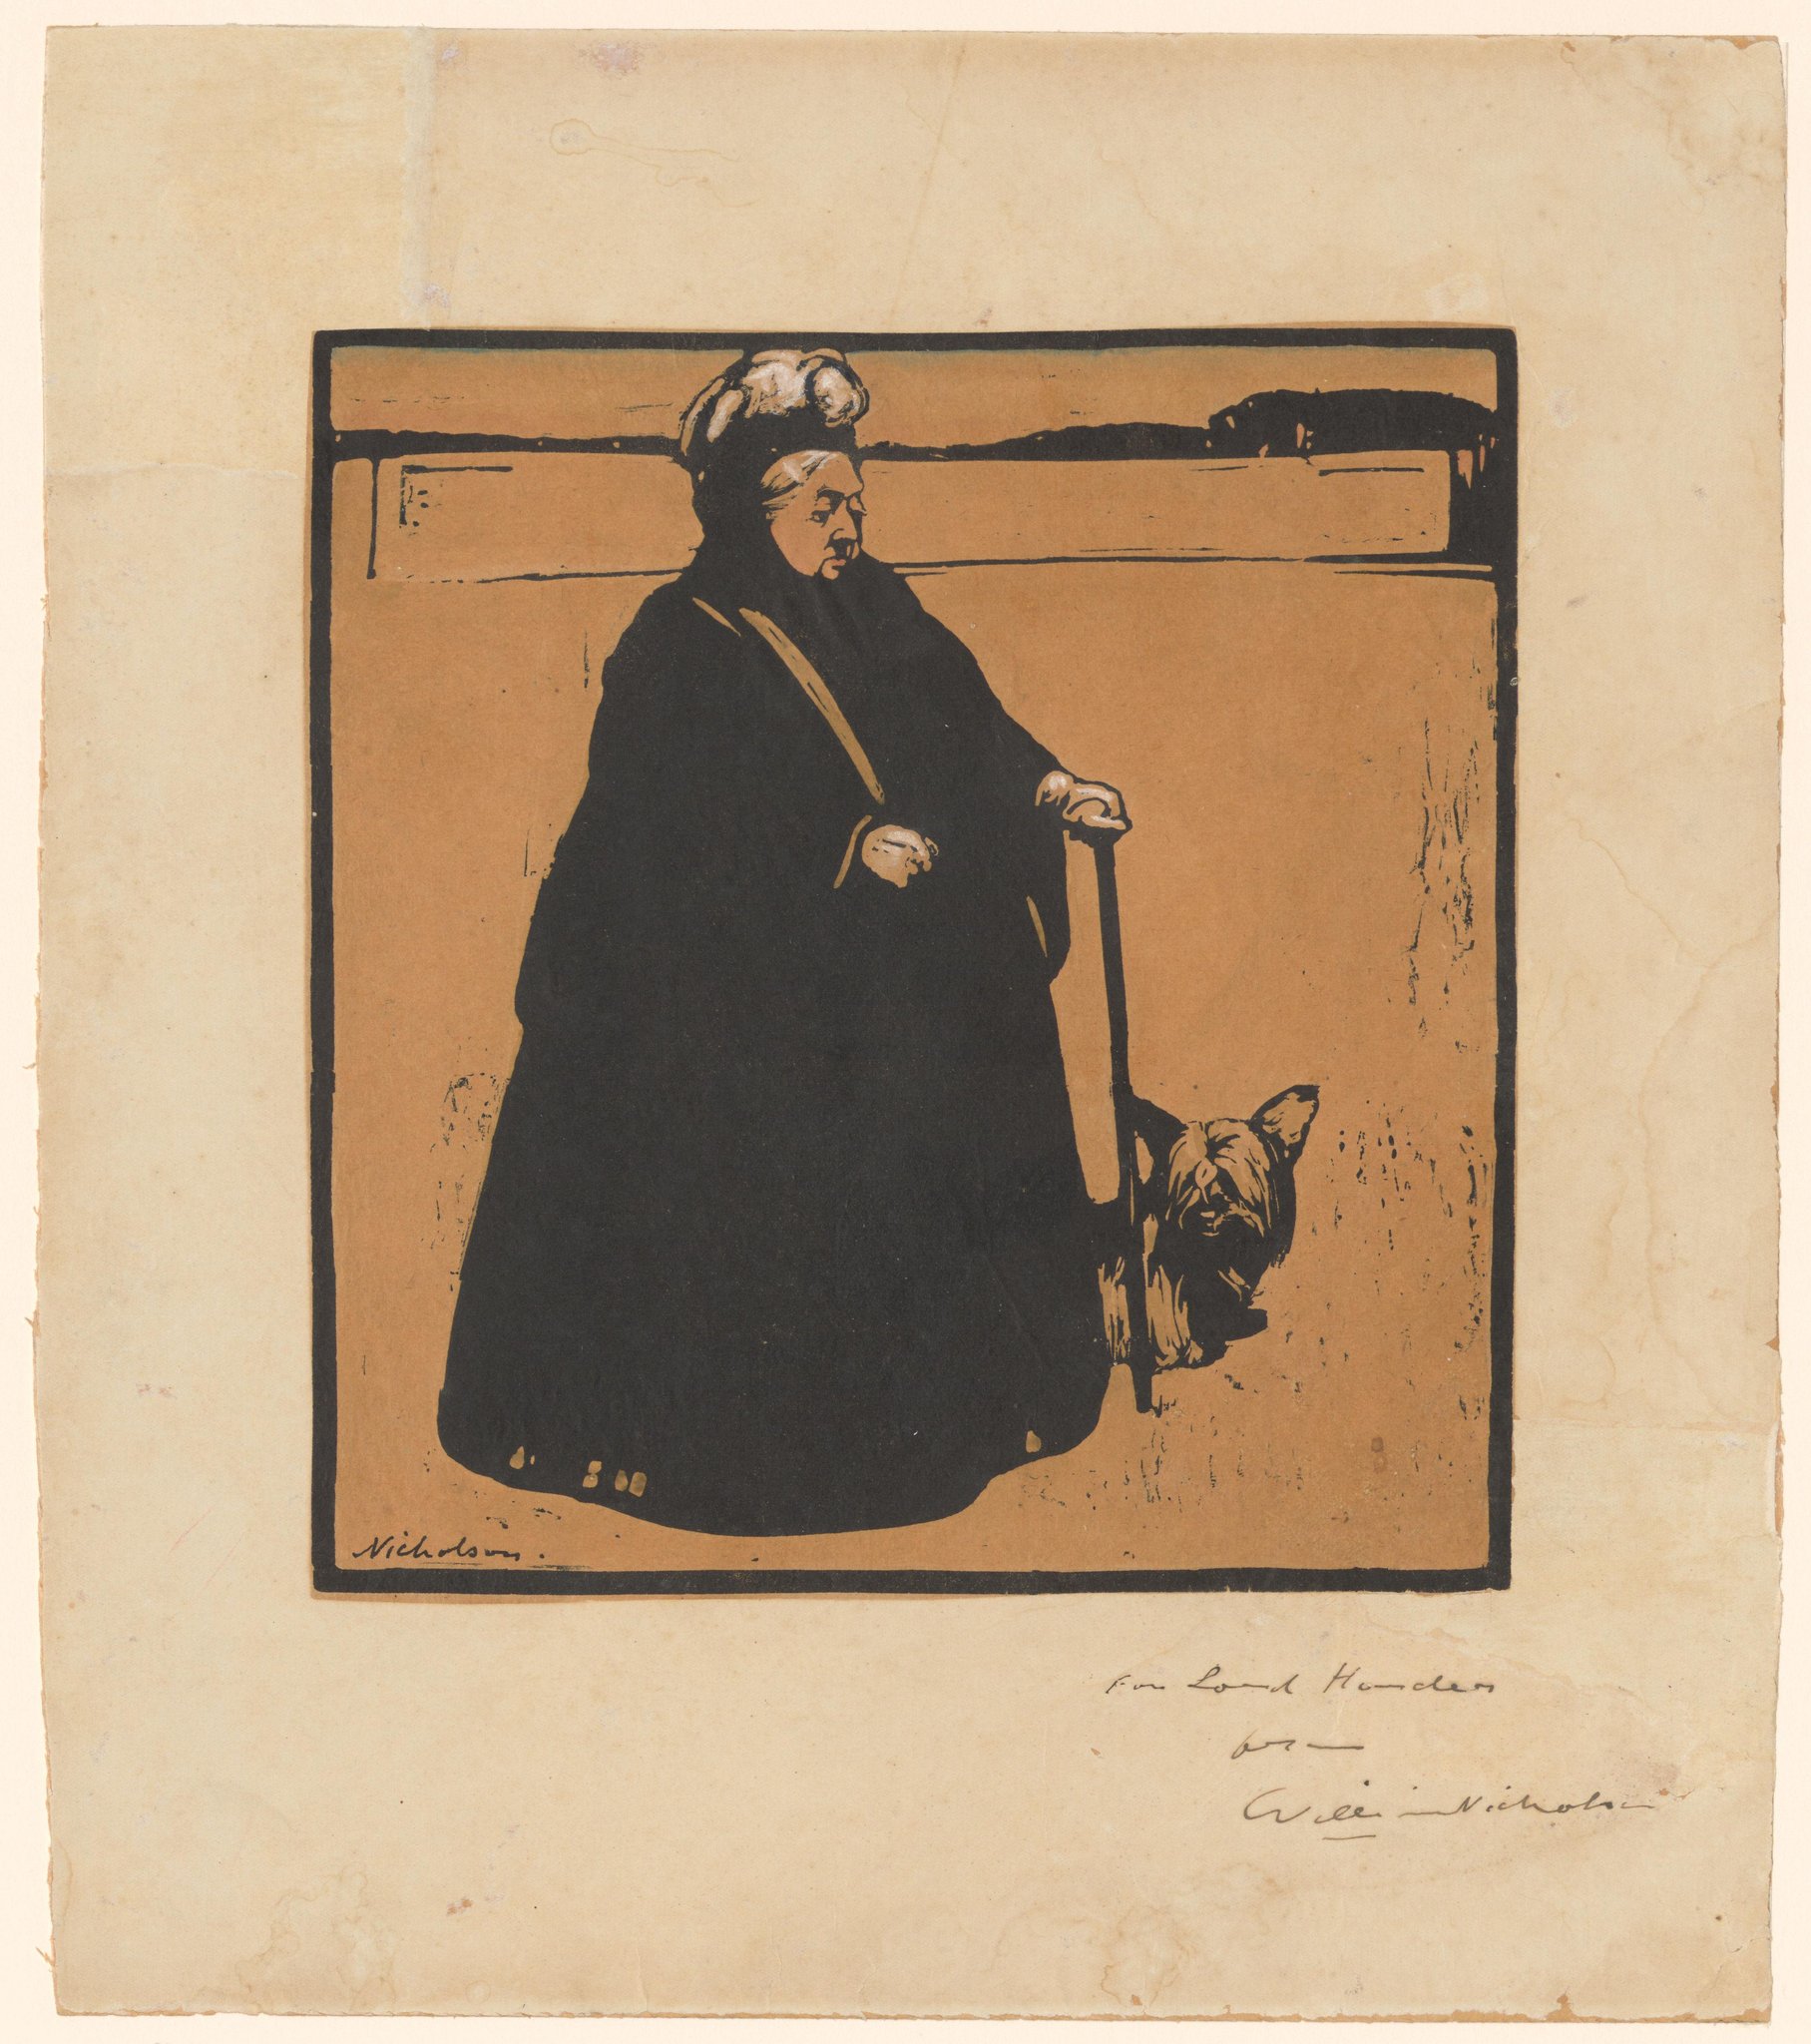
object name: print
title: Portret van koningin Victoria met hond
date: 1897-1899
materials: paper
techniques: hand coloring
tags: victoria (koningin van het verenigd koninkrijk en keizerin van india), historical persons - bb - woman, walking-stick, staff, walking the dog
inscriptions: inscription: ‘For lord H[...]den by William Nicholson’, collector's mark: Lugt 2760, signature: ‘William Nicholson’, collector's mark: Lugt 2228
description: De prent verscheen ter gelegenheid van het 60-jarig regeringsjubileum van koningin Victoria. De prent is in 1897 uitgegeven en ook als lithografie verschenen in The New Review (juni). In 1899 is de prent opnieuw uitgegeven in de serie 'Twelve Portraits'. Proefdruk vóór oplage in 'Twelve Portraits'. Houtblok is voor die uitgave herbewerkt.